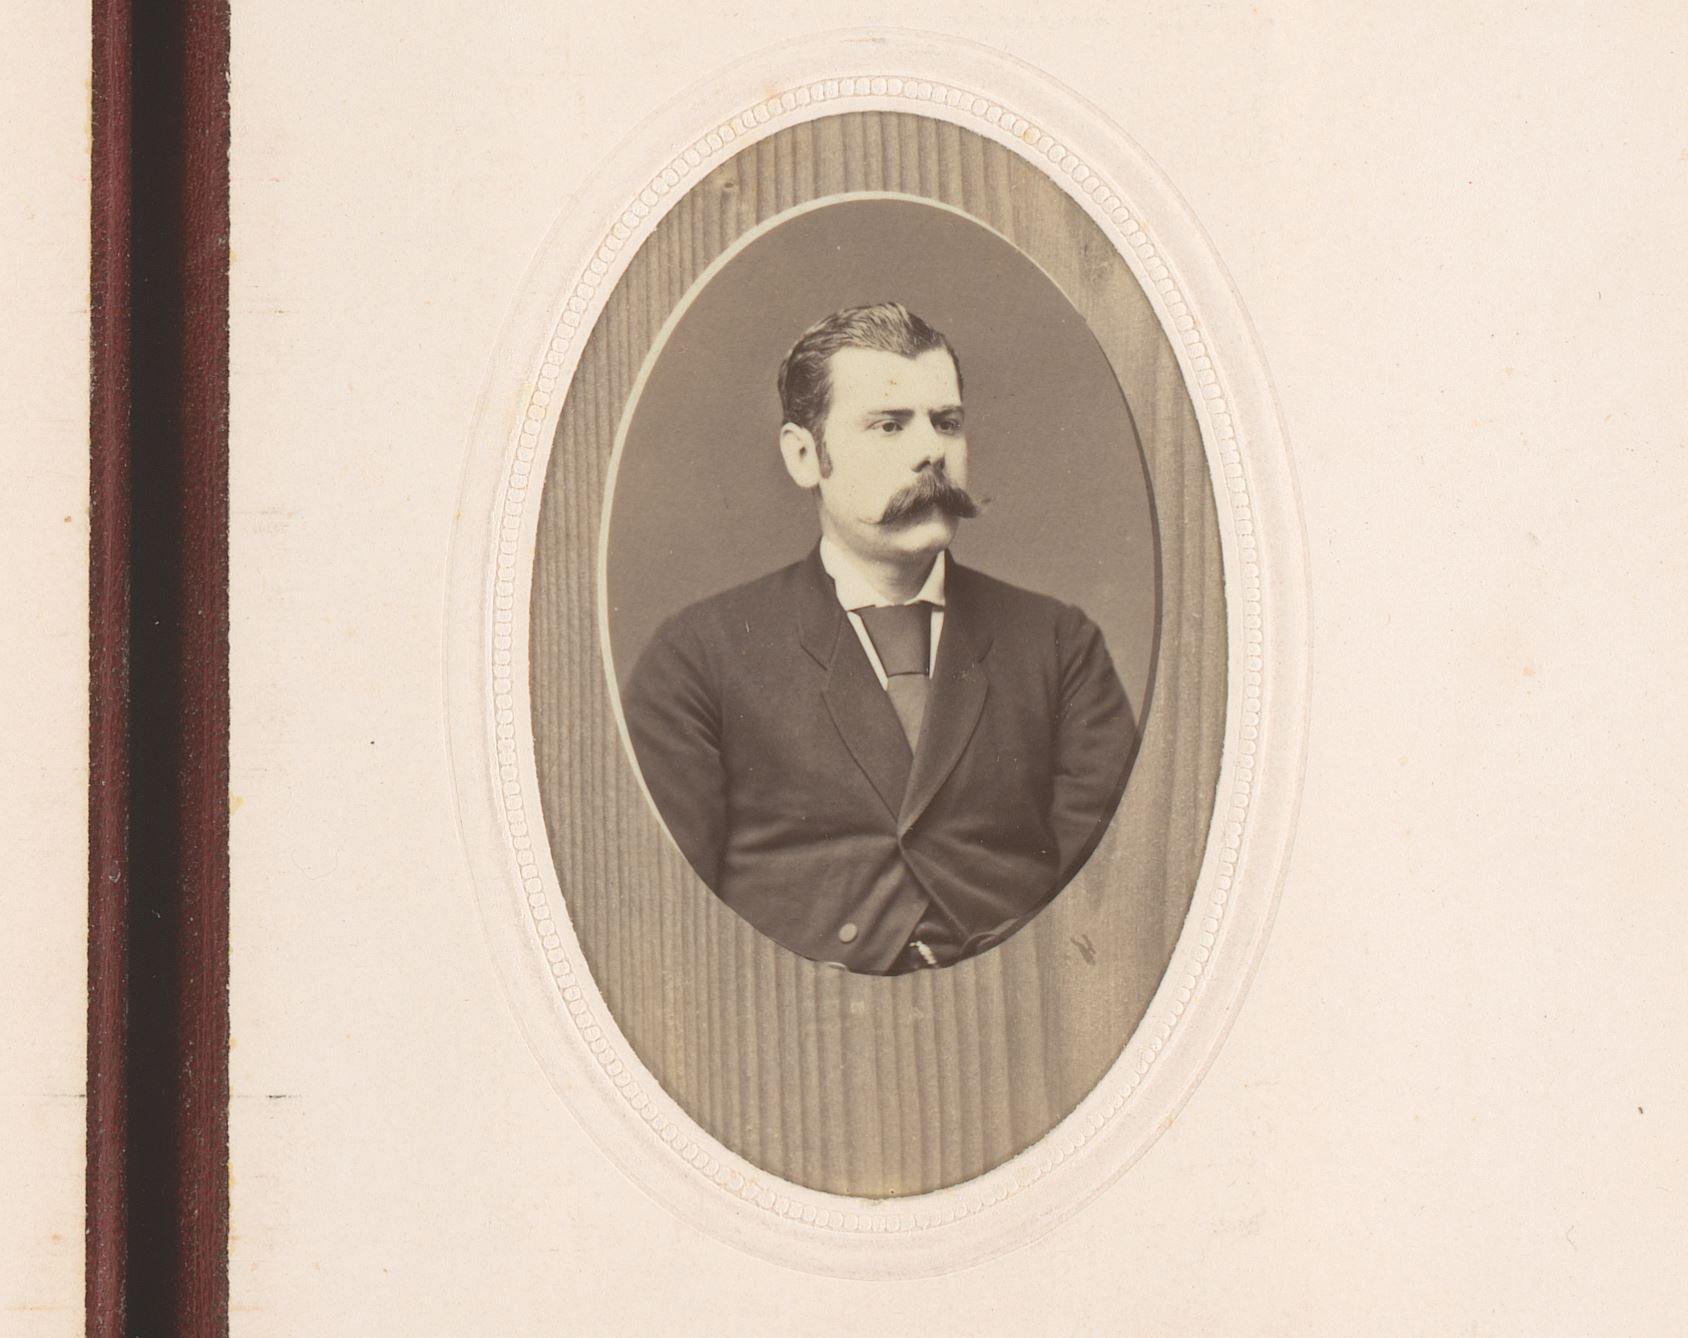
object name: album leaf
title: Portret van een man met snor met achtergrond met houtstructuur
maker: alexandre ken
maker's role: fotograaf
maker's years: 1828-1874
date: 1860-1890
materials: cardboard, celluloid, photographic support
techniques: albumen print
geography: paris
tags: moustache, historical persons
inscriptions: inscription: ‘10 Boulevard Montmartre, Paris’